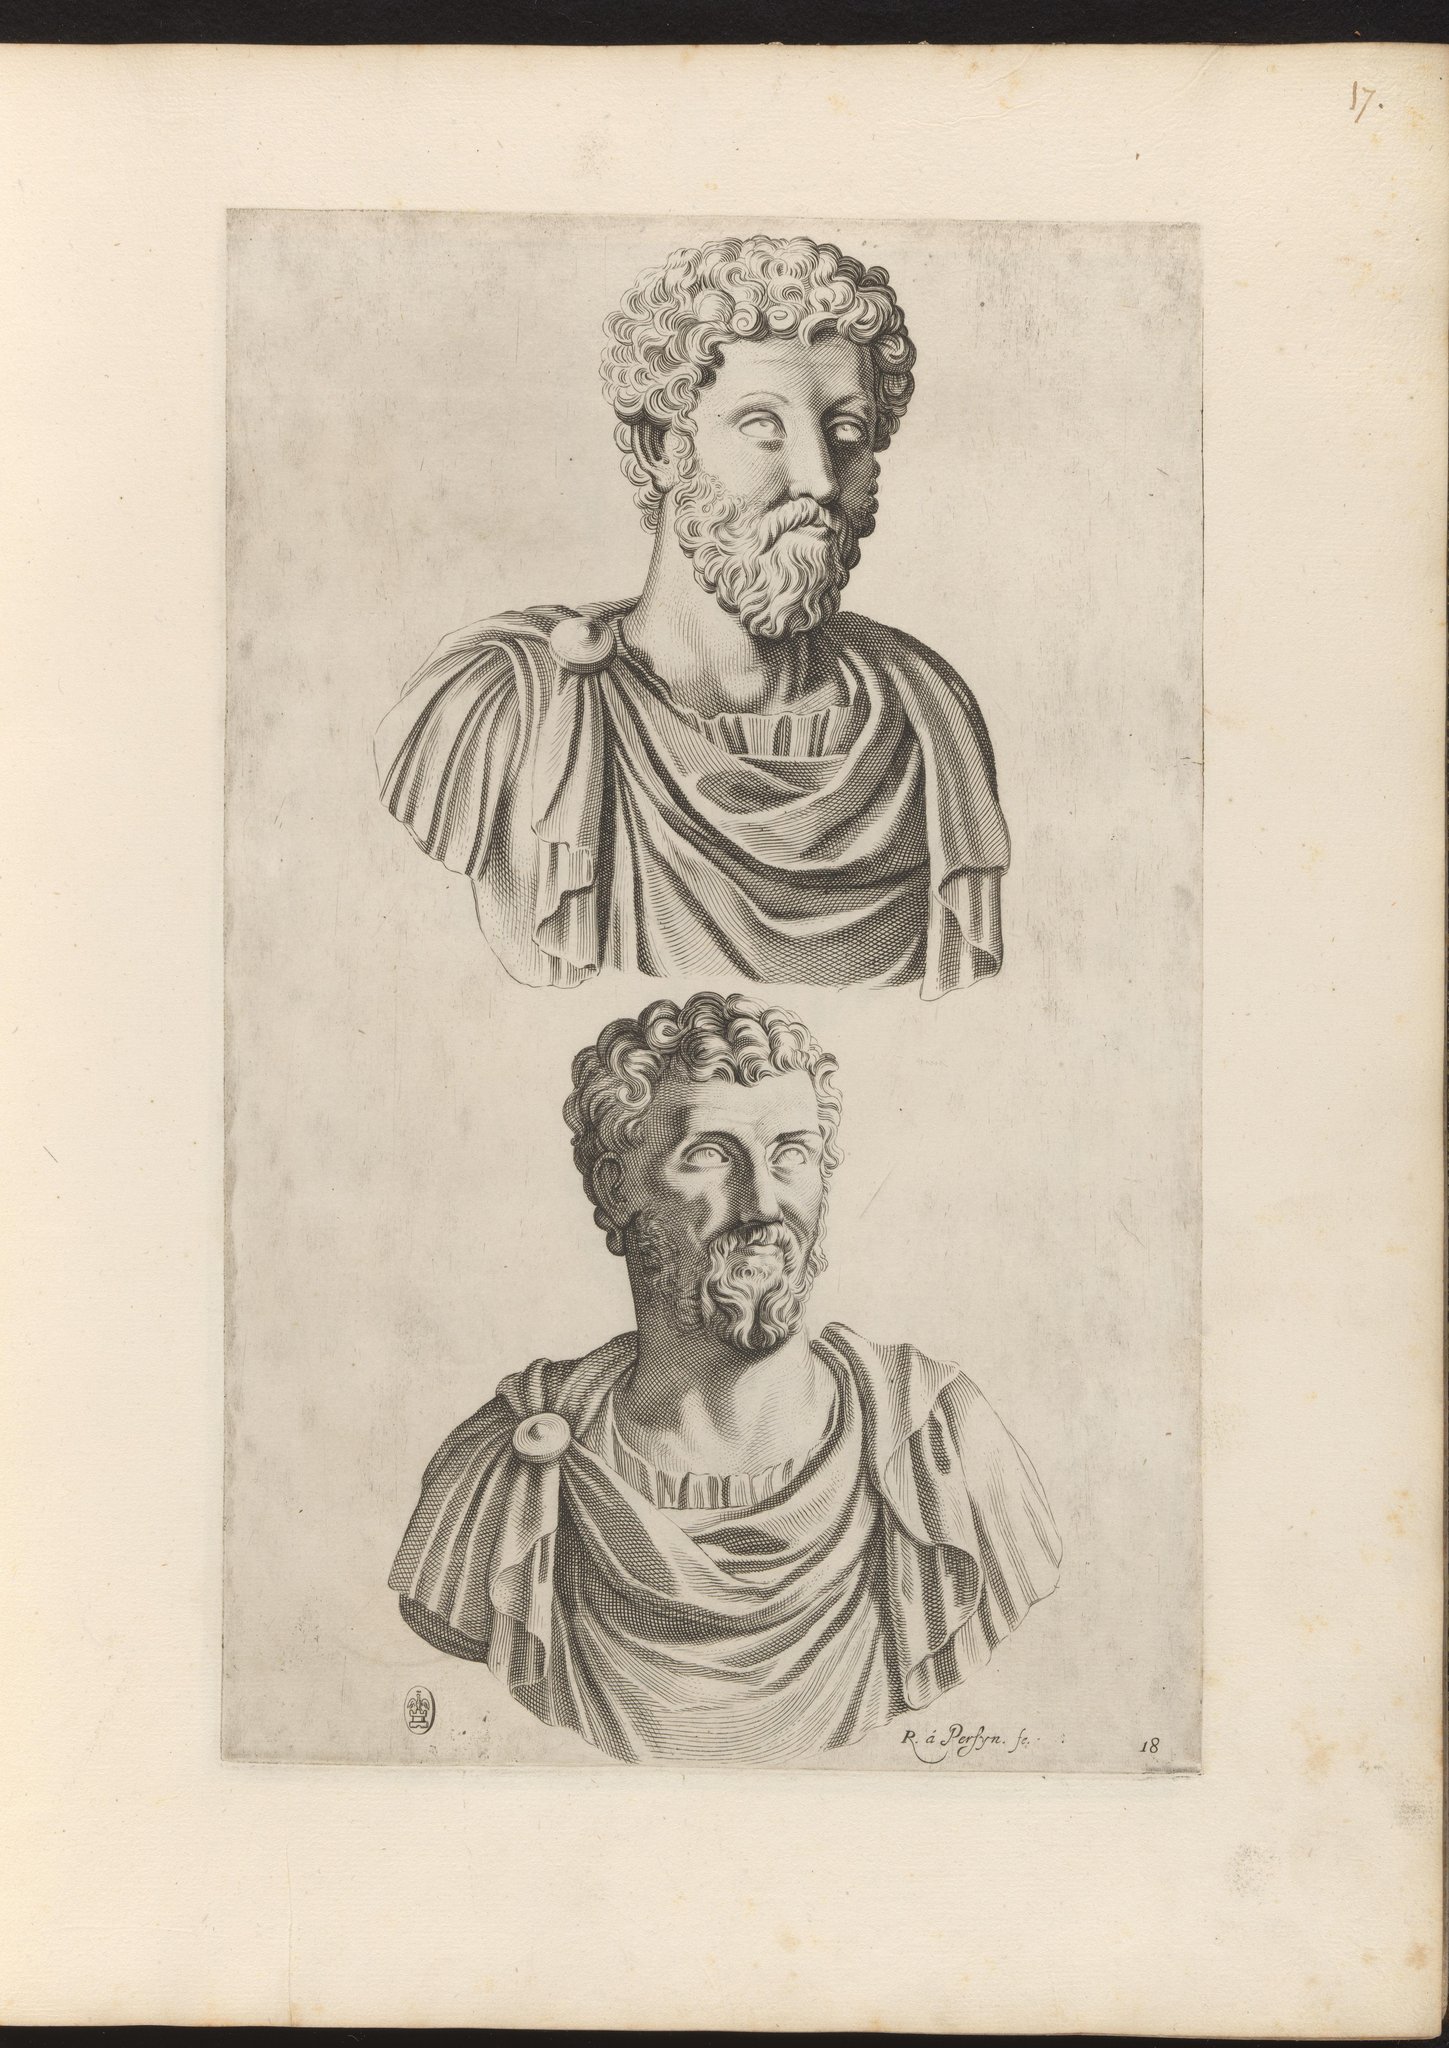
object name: print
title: Twee portretbustes van keizer Marcus Aurelius en keizer Septimius Severus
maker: reinier van persijn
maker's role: draughtsman, painter, print maker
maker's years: 1614-1668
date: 1636-1647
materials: paper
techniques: engraving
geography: rome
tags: rome, male persons from classical history (+ head, bust, etc.), piece of sculpture, reproduction of a piece of sculpture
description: Twee Romeinse portretbustes van keizer Marcus Aurelius en keizer Septimius Severus. Zij dragen een toga. Linksonder het wapenschild van Vincenzo Giustiniani. Prent maakt deel uit van een album met een serie prenten naar de sculpturen in de verzameling in de Galleria Giustiniani te Rome.